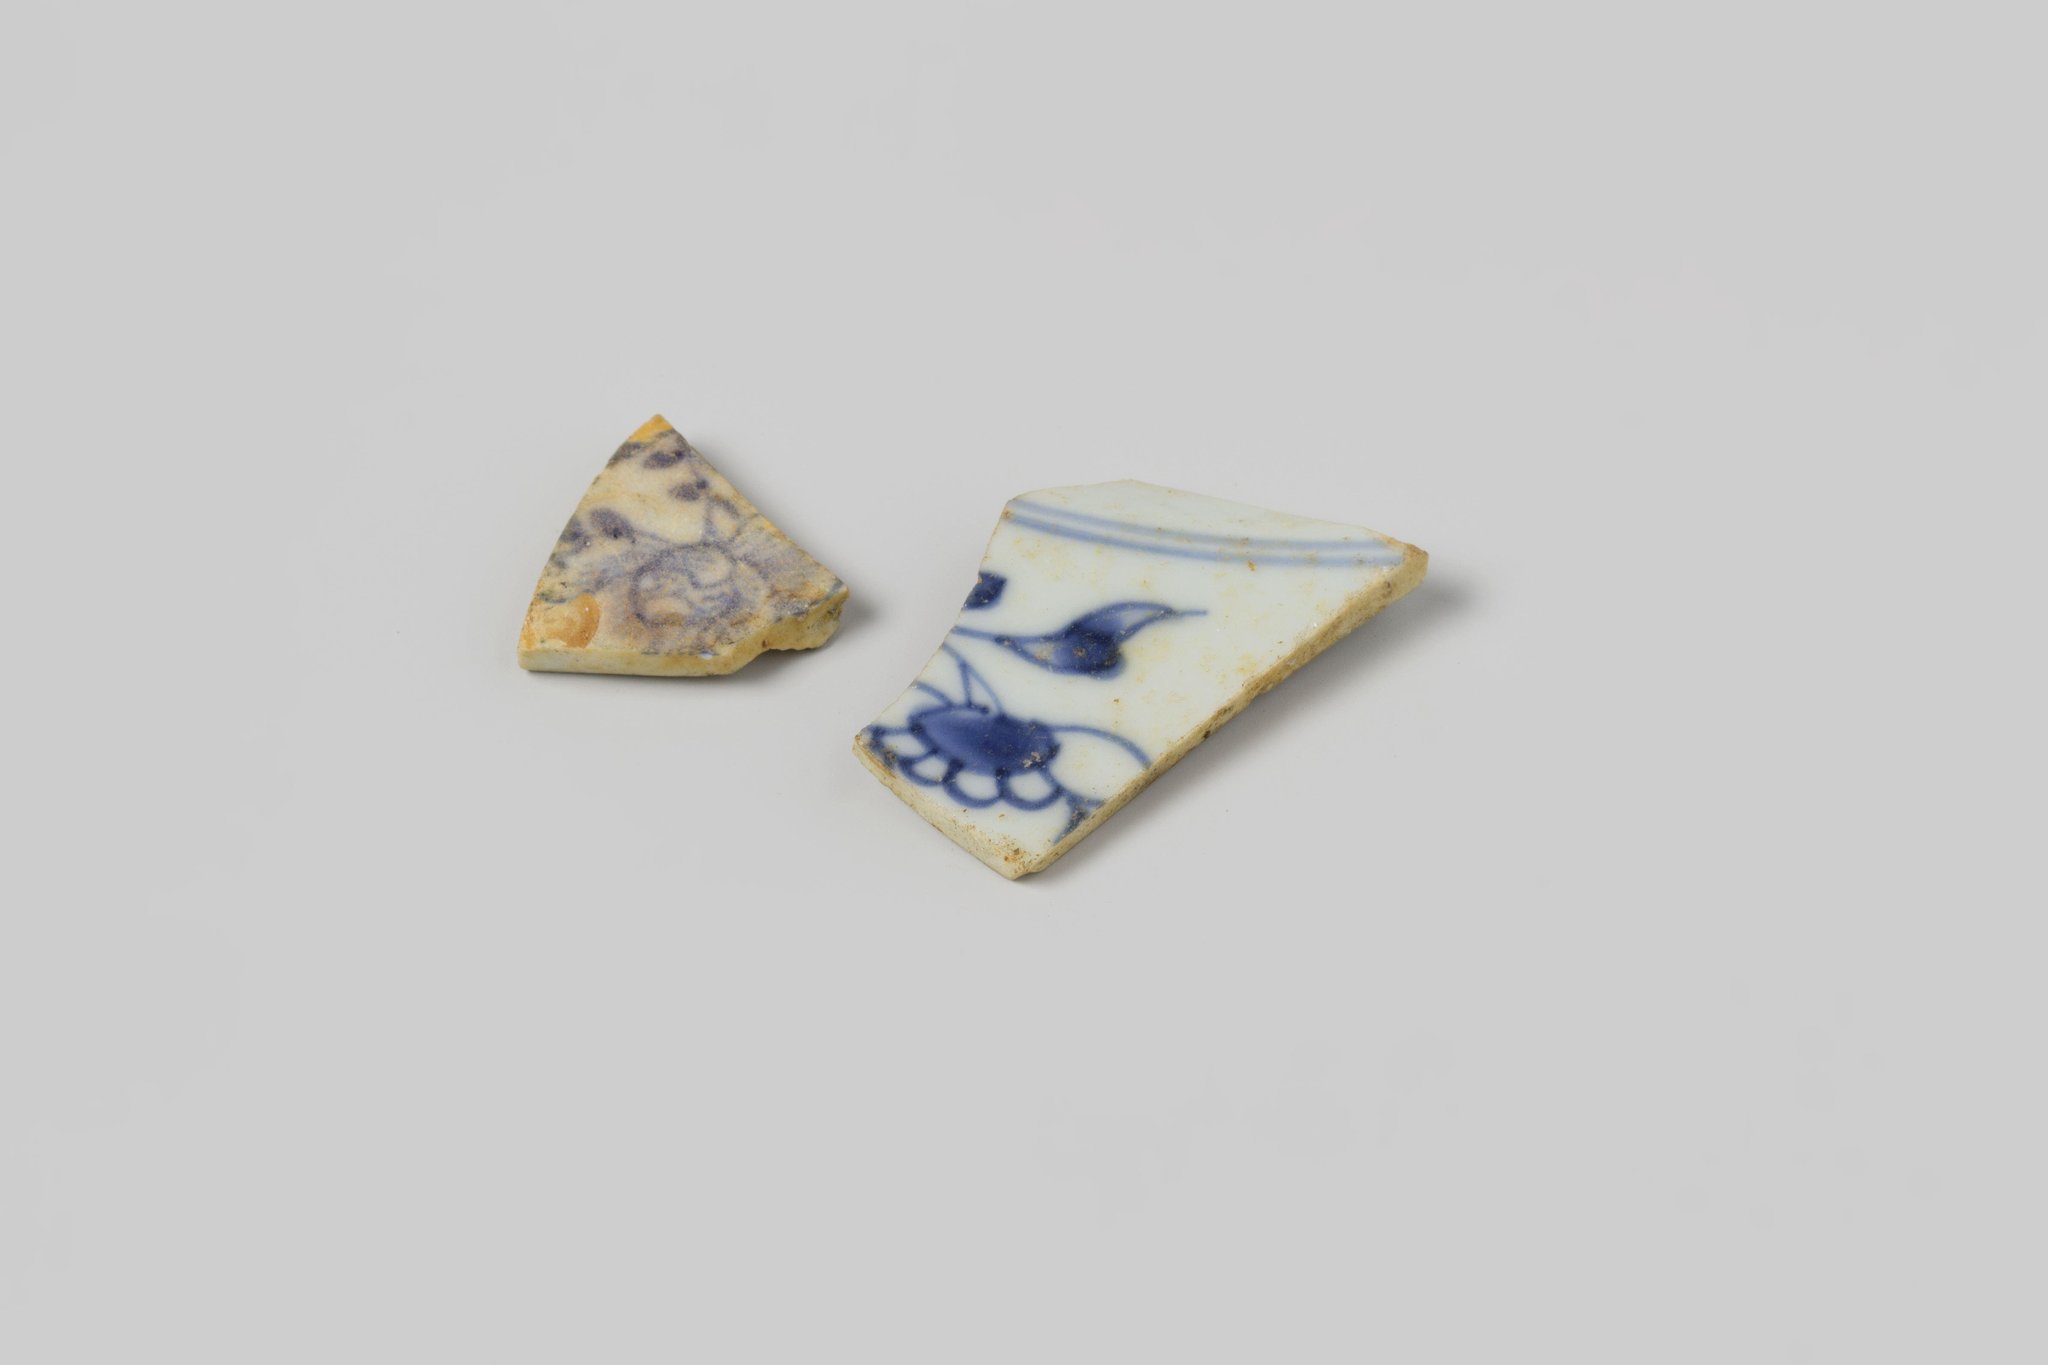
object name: sherd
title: Scherven van borden uit het wrak van de Oost-Indiëvaarder Hollandia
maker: Anonymous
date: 1700-1743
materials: porcelain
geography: netherlands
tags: verenigde oostindische compagnie, hollandia (schip)